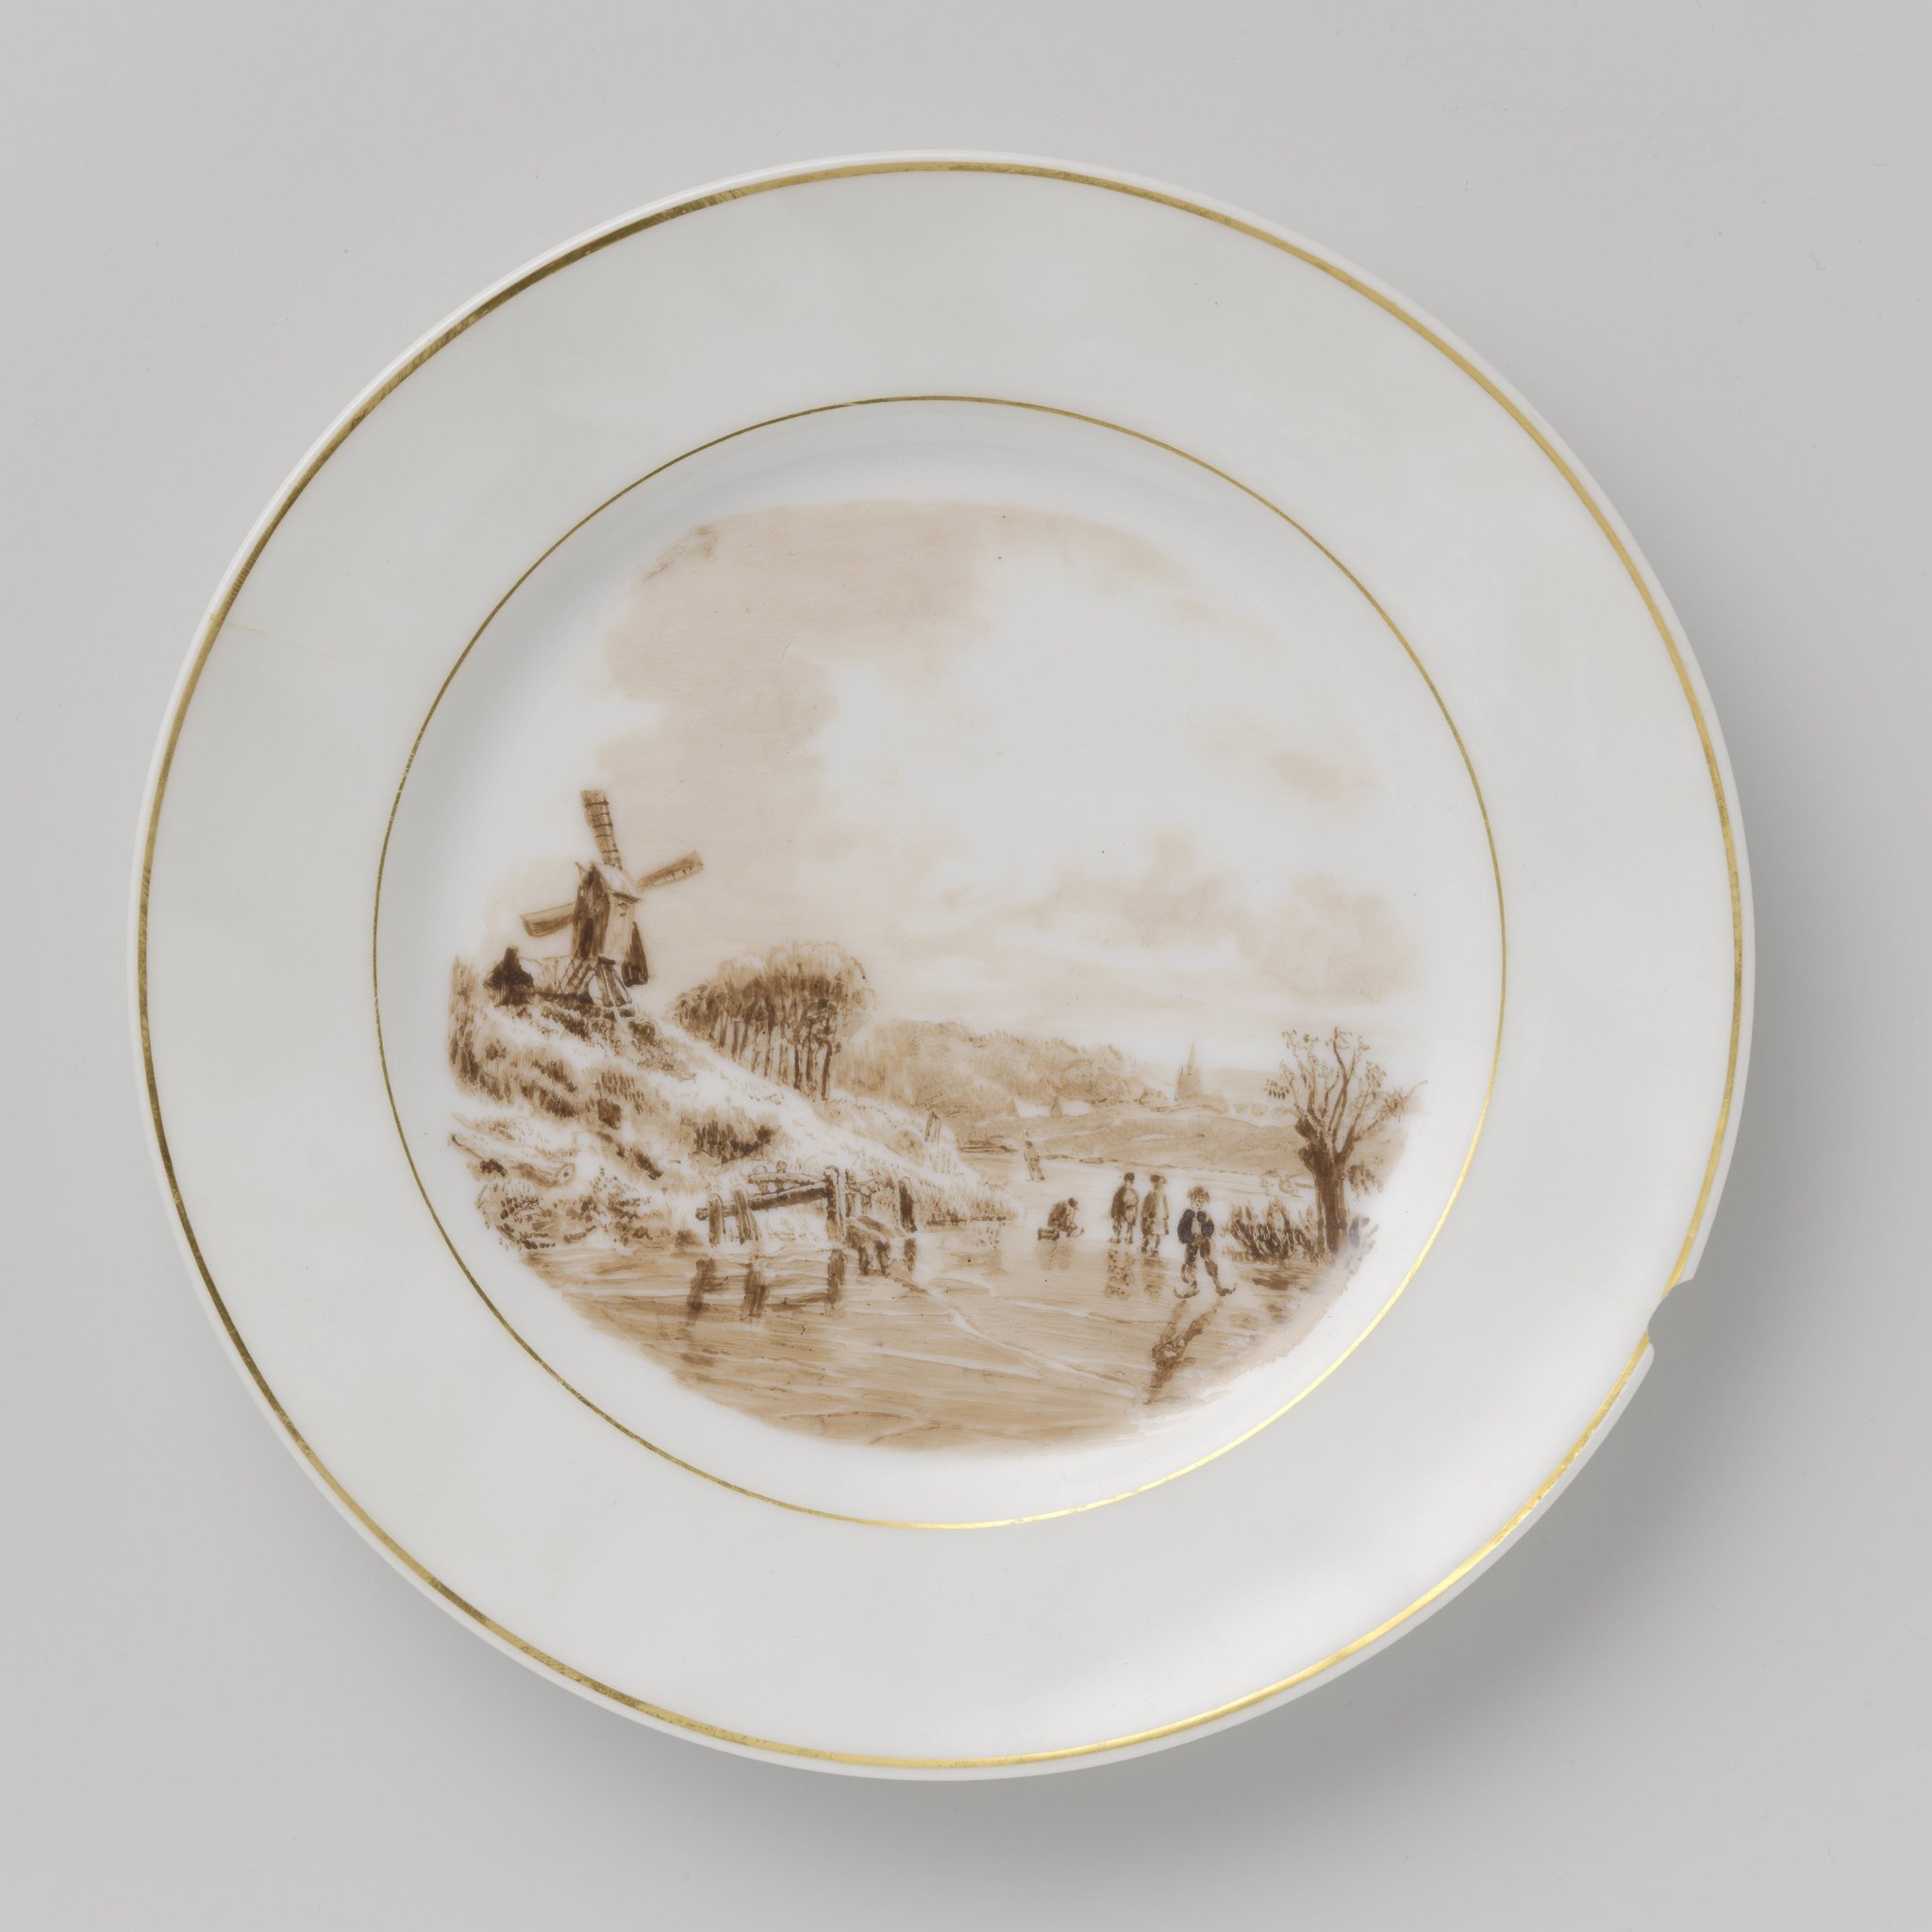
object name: service set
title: Plate with a landscape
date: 1850-1860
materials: glaze, gold, paint, porcelain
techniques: firing, forming, gilding, turning, vitrification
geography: europe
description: Bord van porselein, beschilderd op het glazuur in sepia en goud. Op het plat een landschap met een molen en schaatsende mensen op een bevroren rivier.